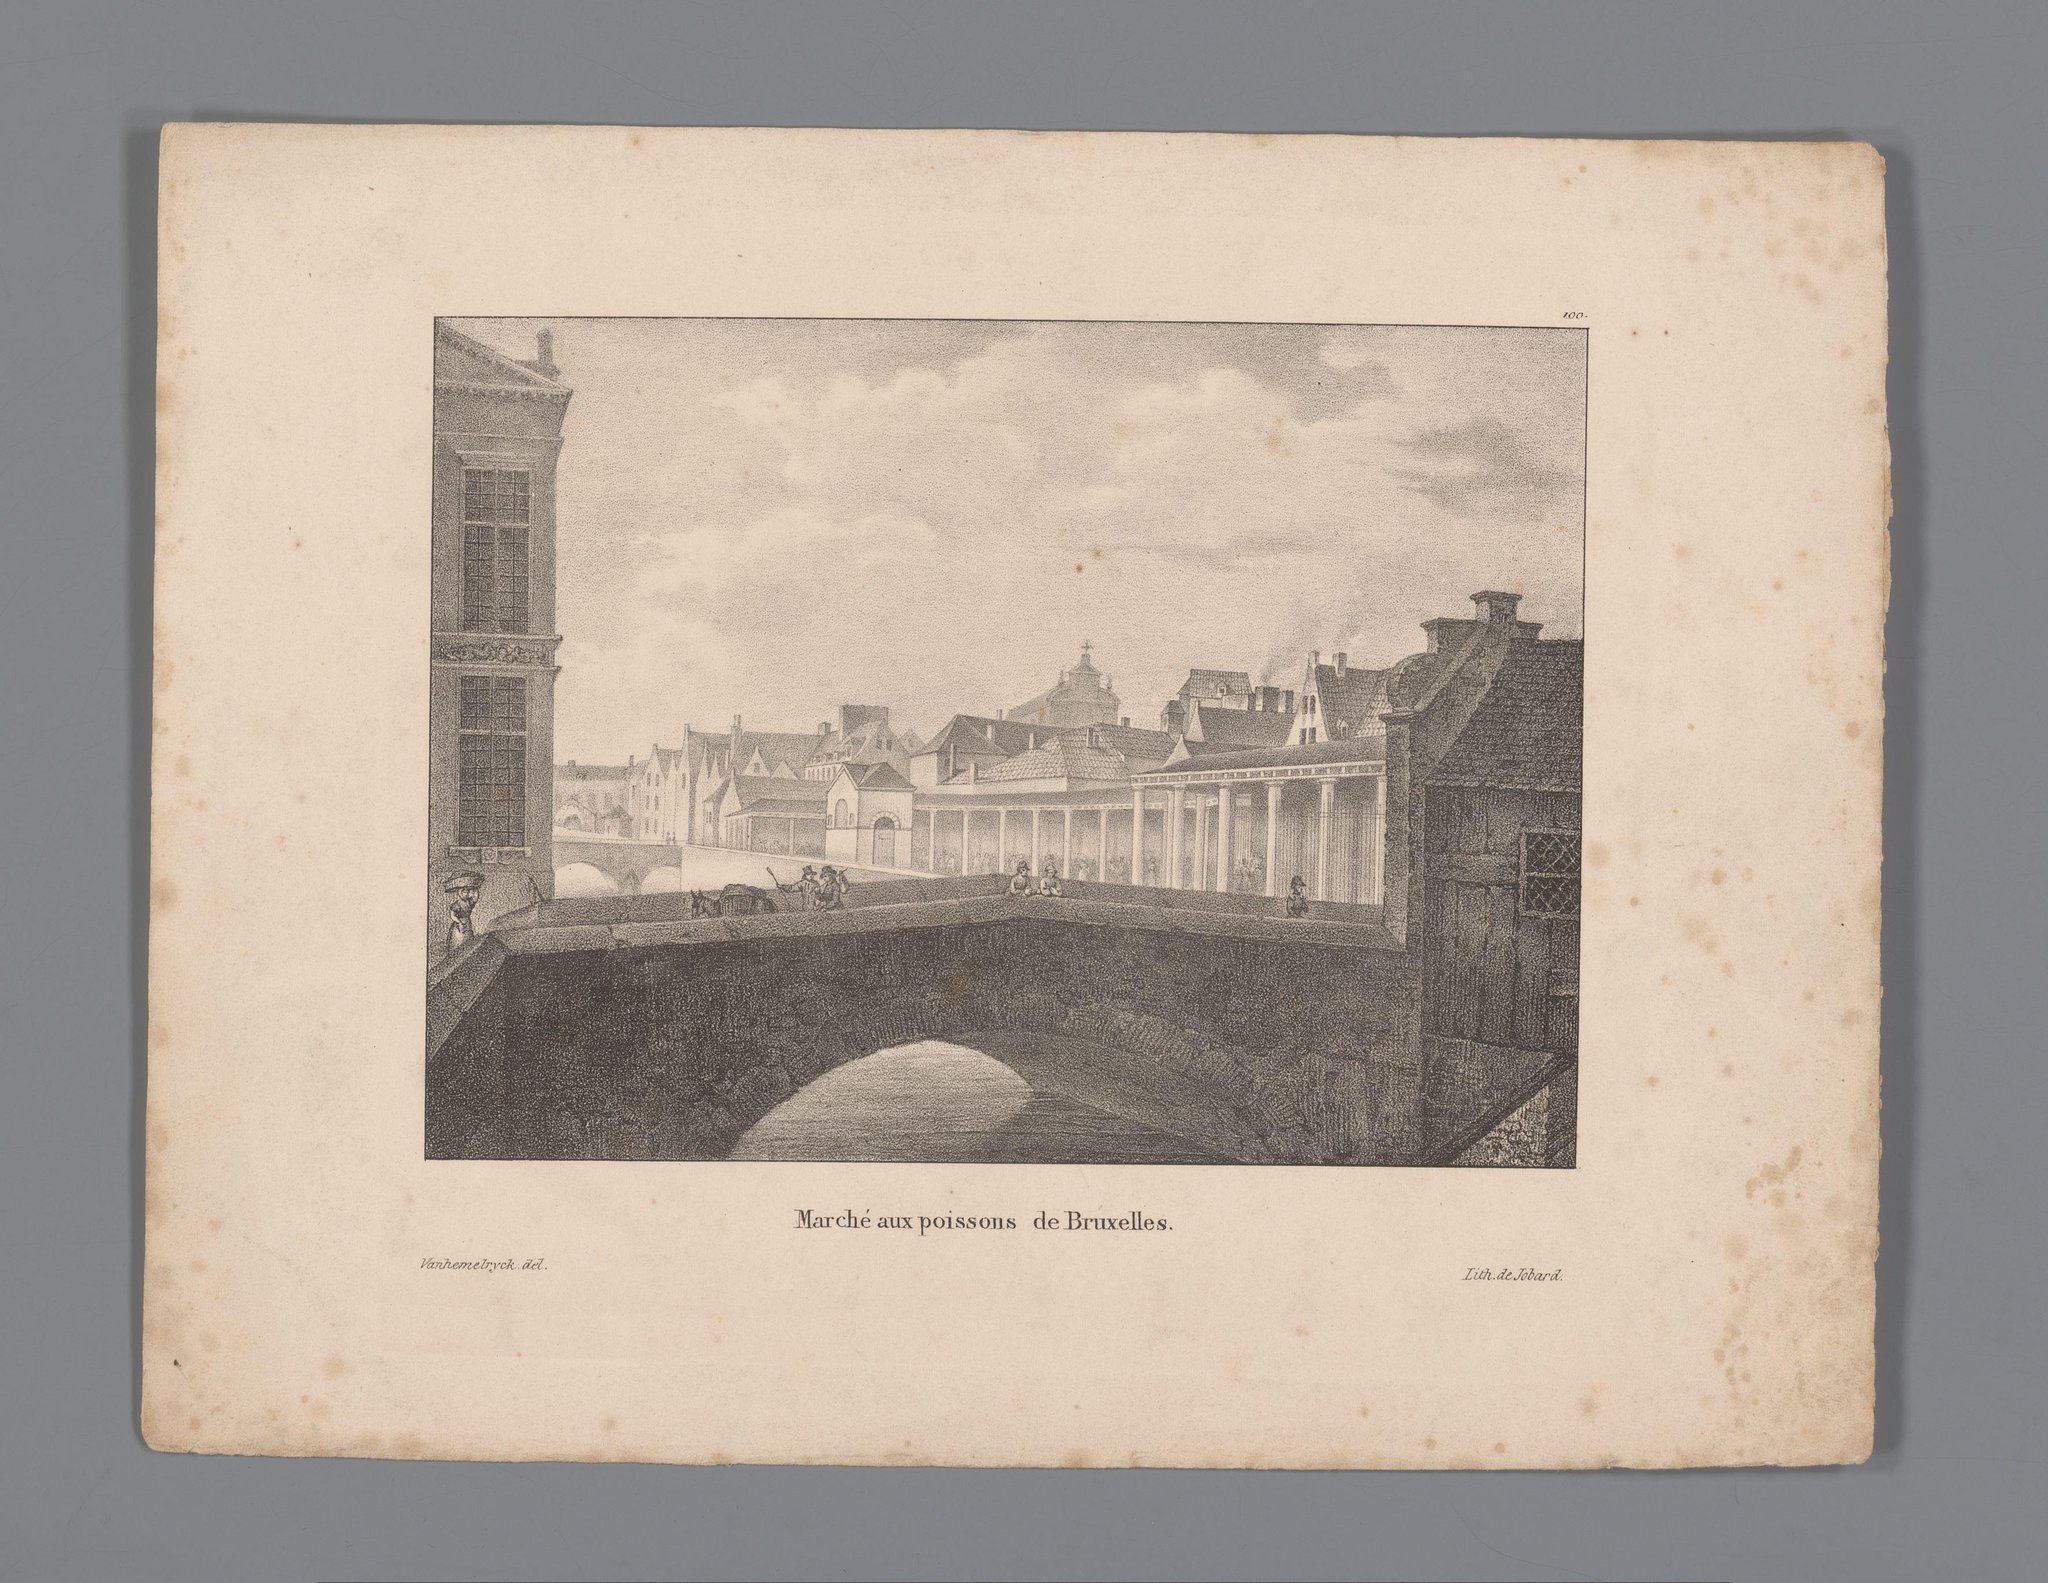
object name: print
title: Gezicht op de Vismarkt te Brussel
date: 1802-1861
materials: paper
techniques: lithograph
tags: city-view, and landscape with man-made constructions, market, bridge in city across river, canal, etc., brussels